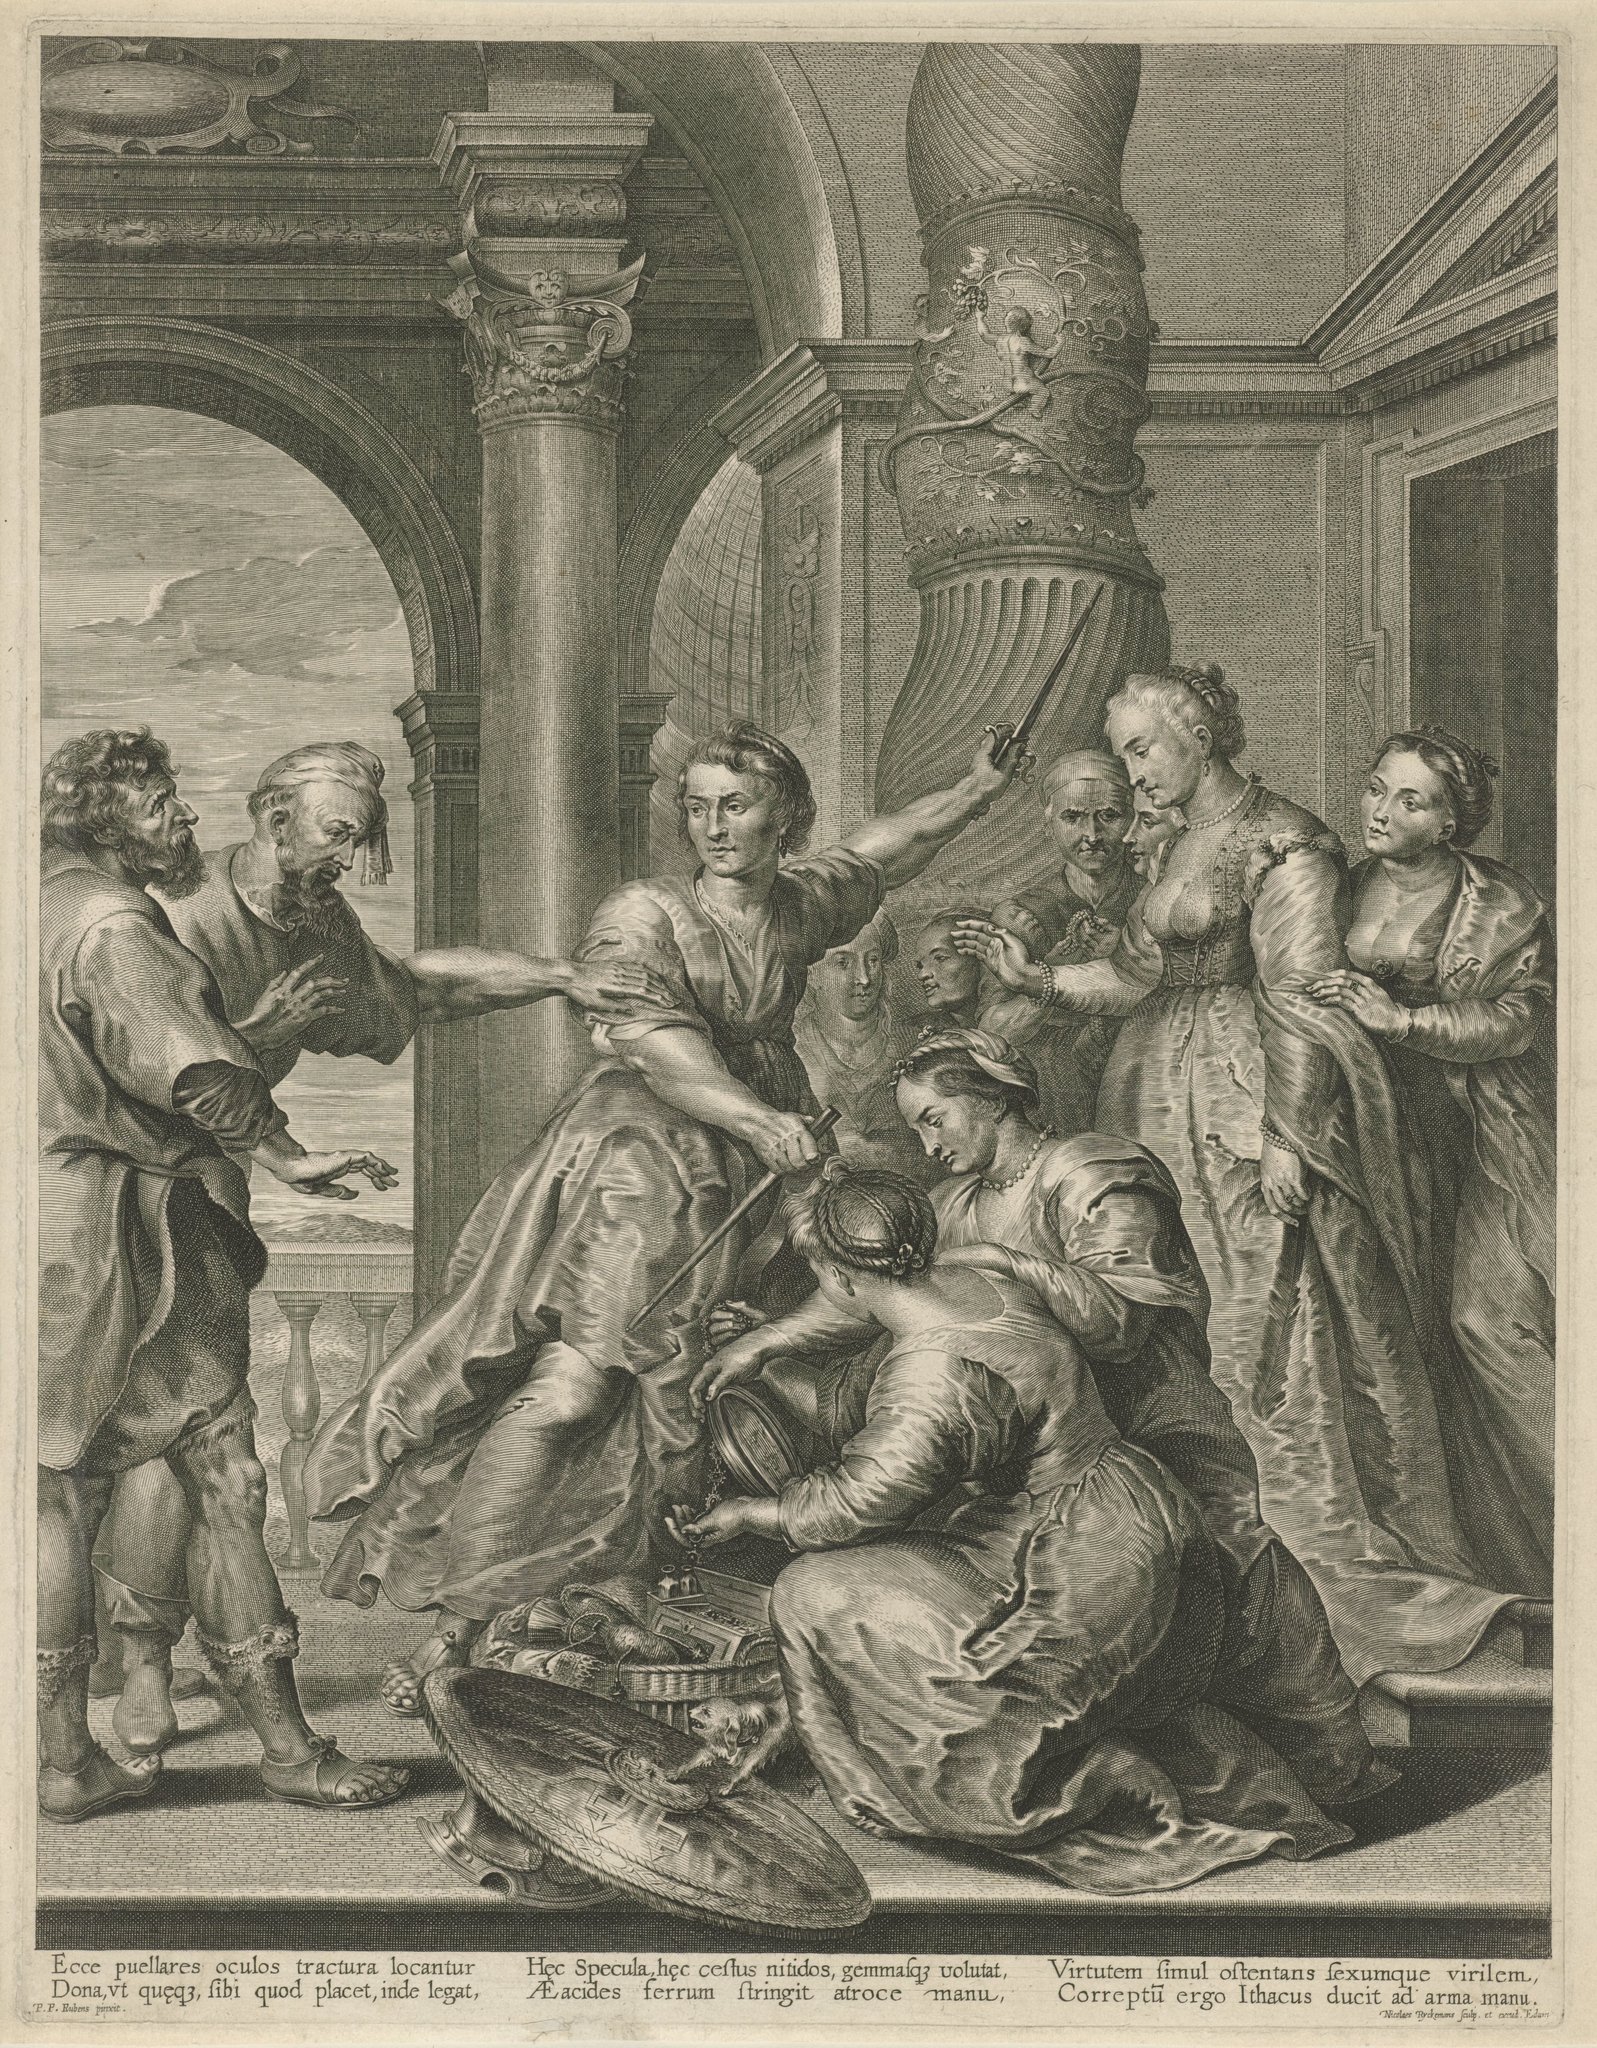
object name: print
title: Achilles en de dochters van Lycomedes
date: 1616-1636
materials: paper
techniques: engraving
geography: edam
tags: achilles discovered among the daughters of lycomedes, i.e. achilles on scyros: when presents are brought achilles snatches up the weapons and thus betrays his identity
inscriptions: collector's mark: Lugt 240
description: De dochters van Lycomedes zitten gebogen over een kist met juwelen terwijl Achilles, vermomd als vrouw, zijn zwaard trekt. Achilles wordt door twee mannen bij zijn arm gegrepen.